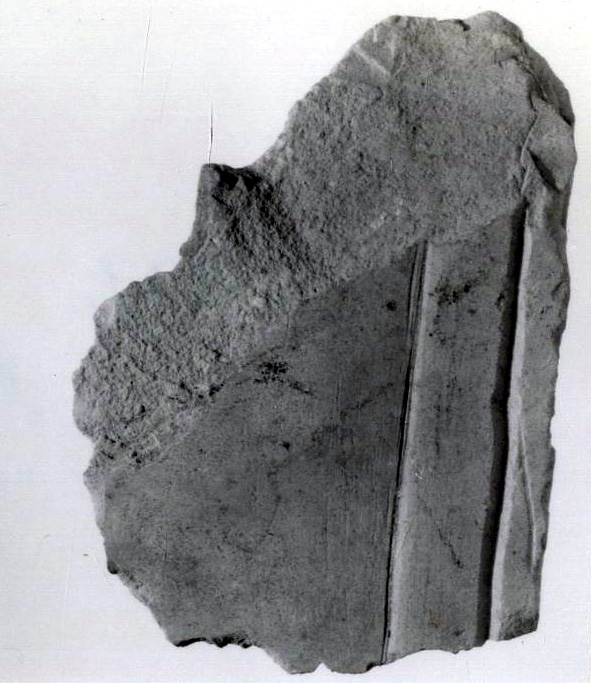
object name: relief fragment, tomb of meketre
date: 1981-1975 BCE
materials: limestone, paint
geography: egypt